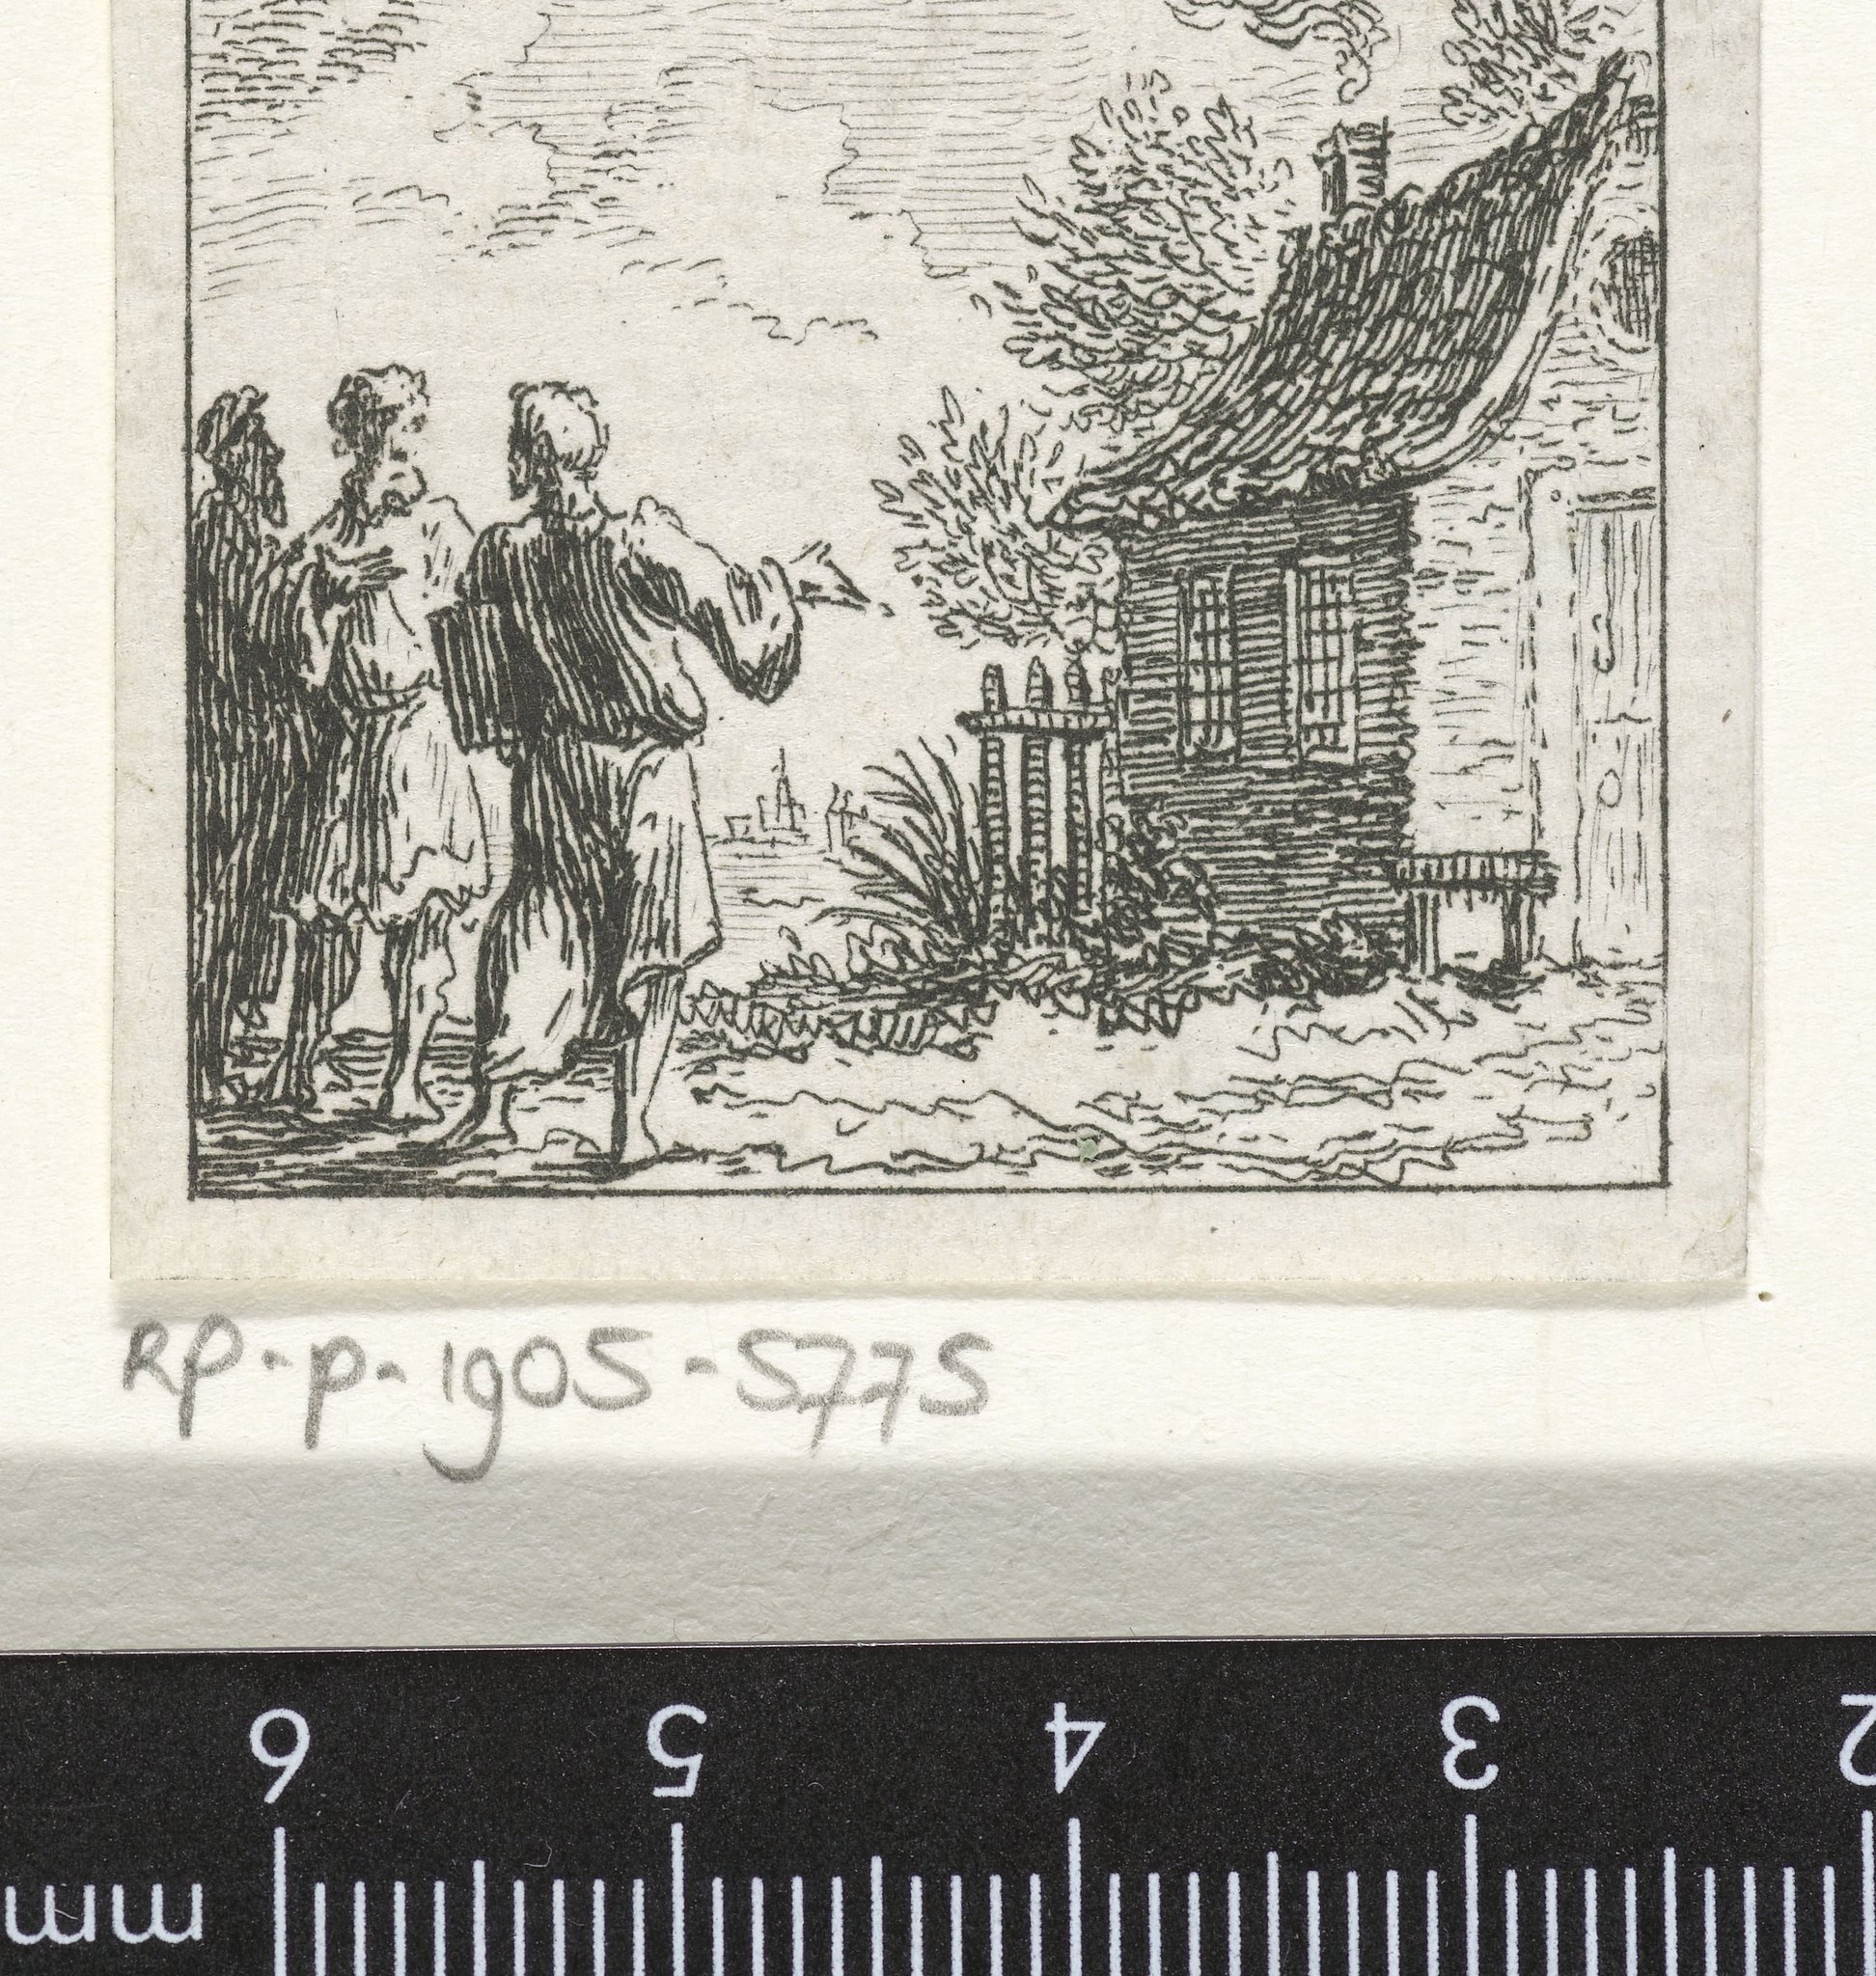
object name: print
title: Illustraties voor fabelvertellingen van Phaedrus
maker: simon fokke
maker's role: draughtsman, print maker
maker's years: 1712-1784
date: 1769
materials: paper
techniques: etching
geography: amsterdam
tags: fables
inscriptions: collector's mark: Lugt 2228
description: Drie mannen voeren voor een huis een gesprek. Deze illustratie is vervaardigd bij de Aesopische fabels van de Latijnse dichter Phaedrus.